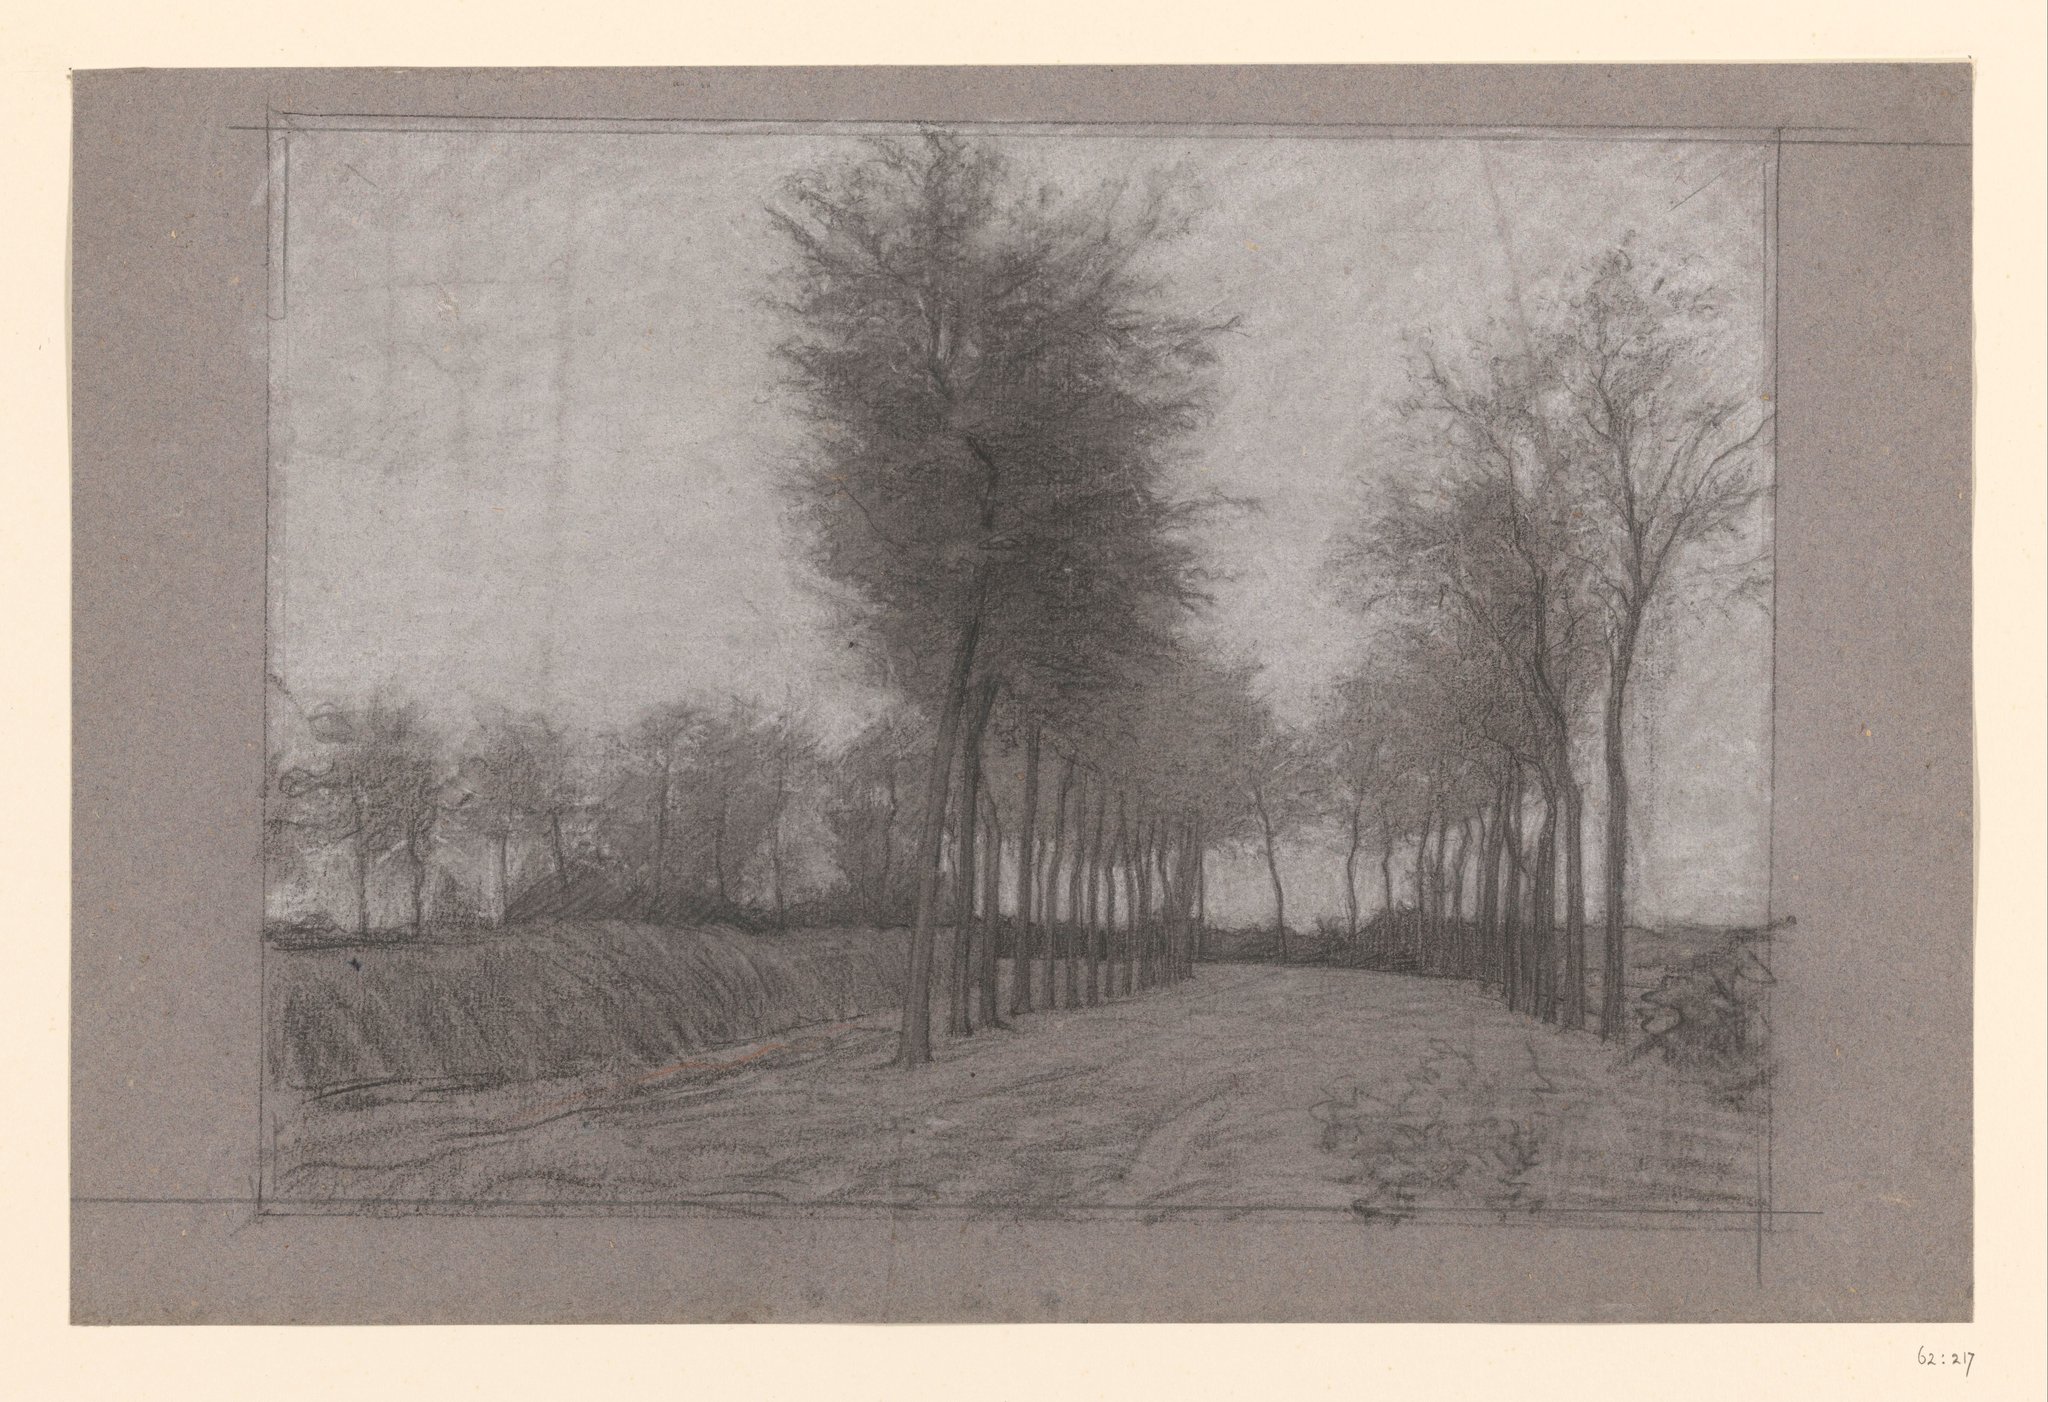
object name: drawing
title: Landweg met bomen aan weerszijden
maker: jan veth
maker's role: designer, draughtsman, painter, print maker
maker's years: 1864-1925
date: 1874-1925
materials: chalk, paper